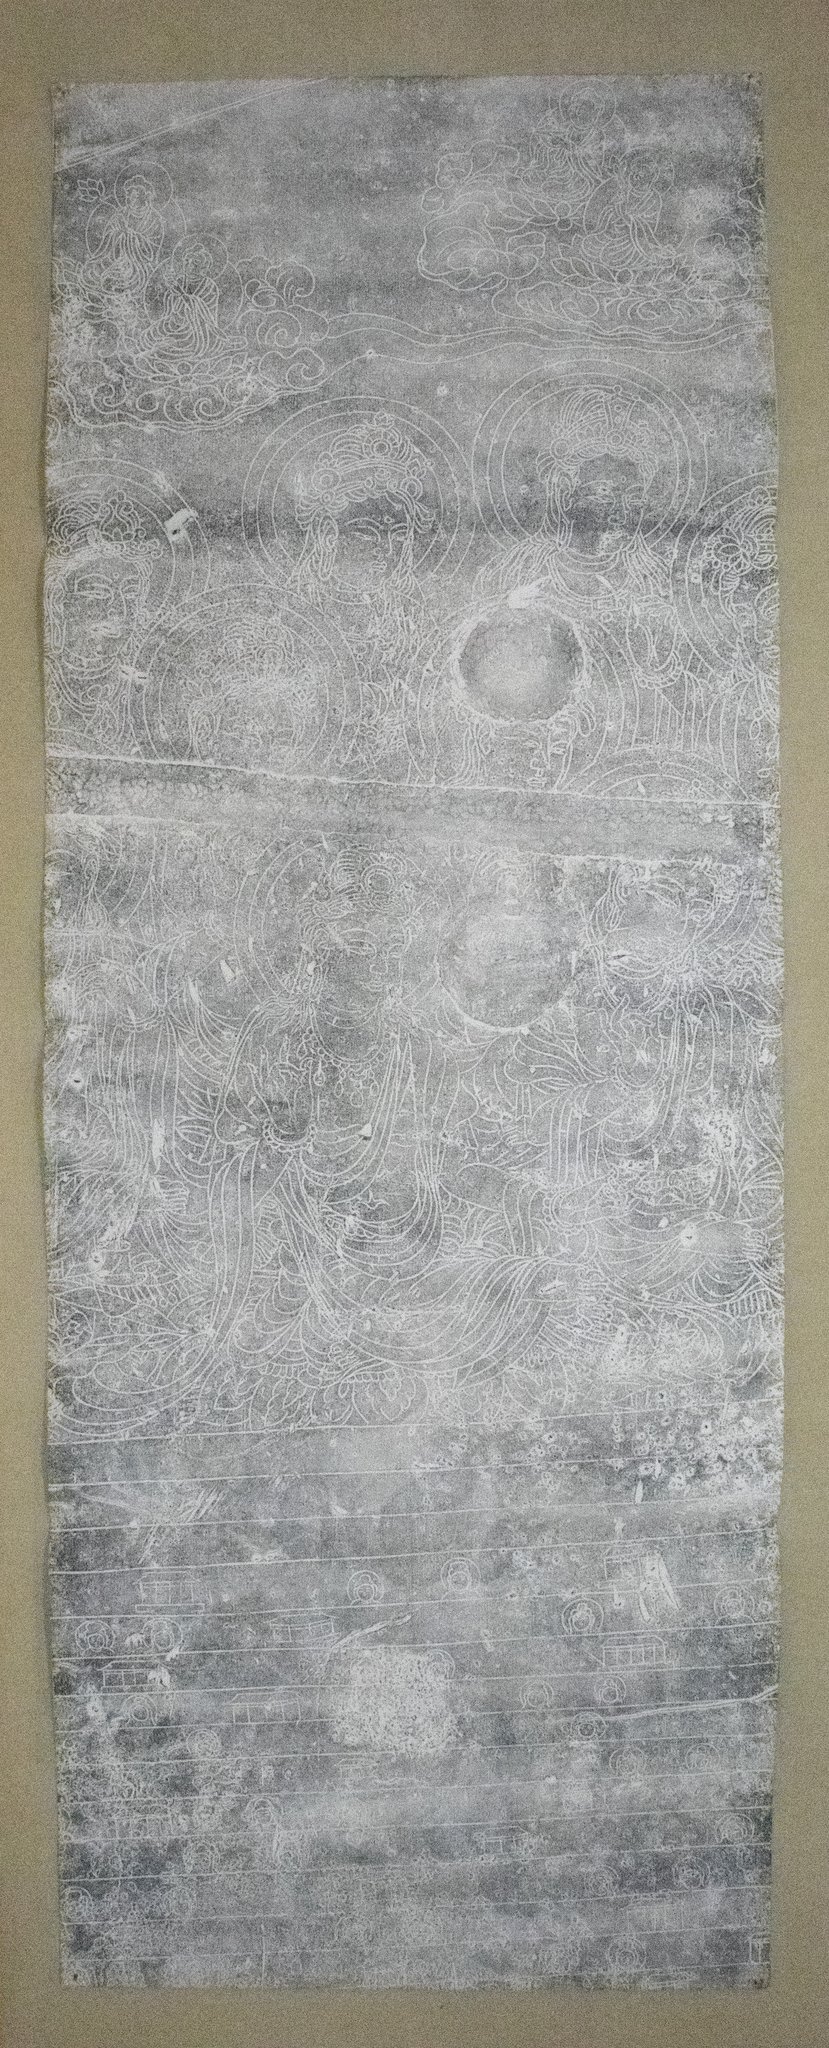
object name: rubbing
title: Rubbing from the Daibutsu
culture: japanese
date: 1901-2000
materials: ink, paper